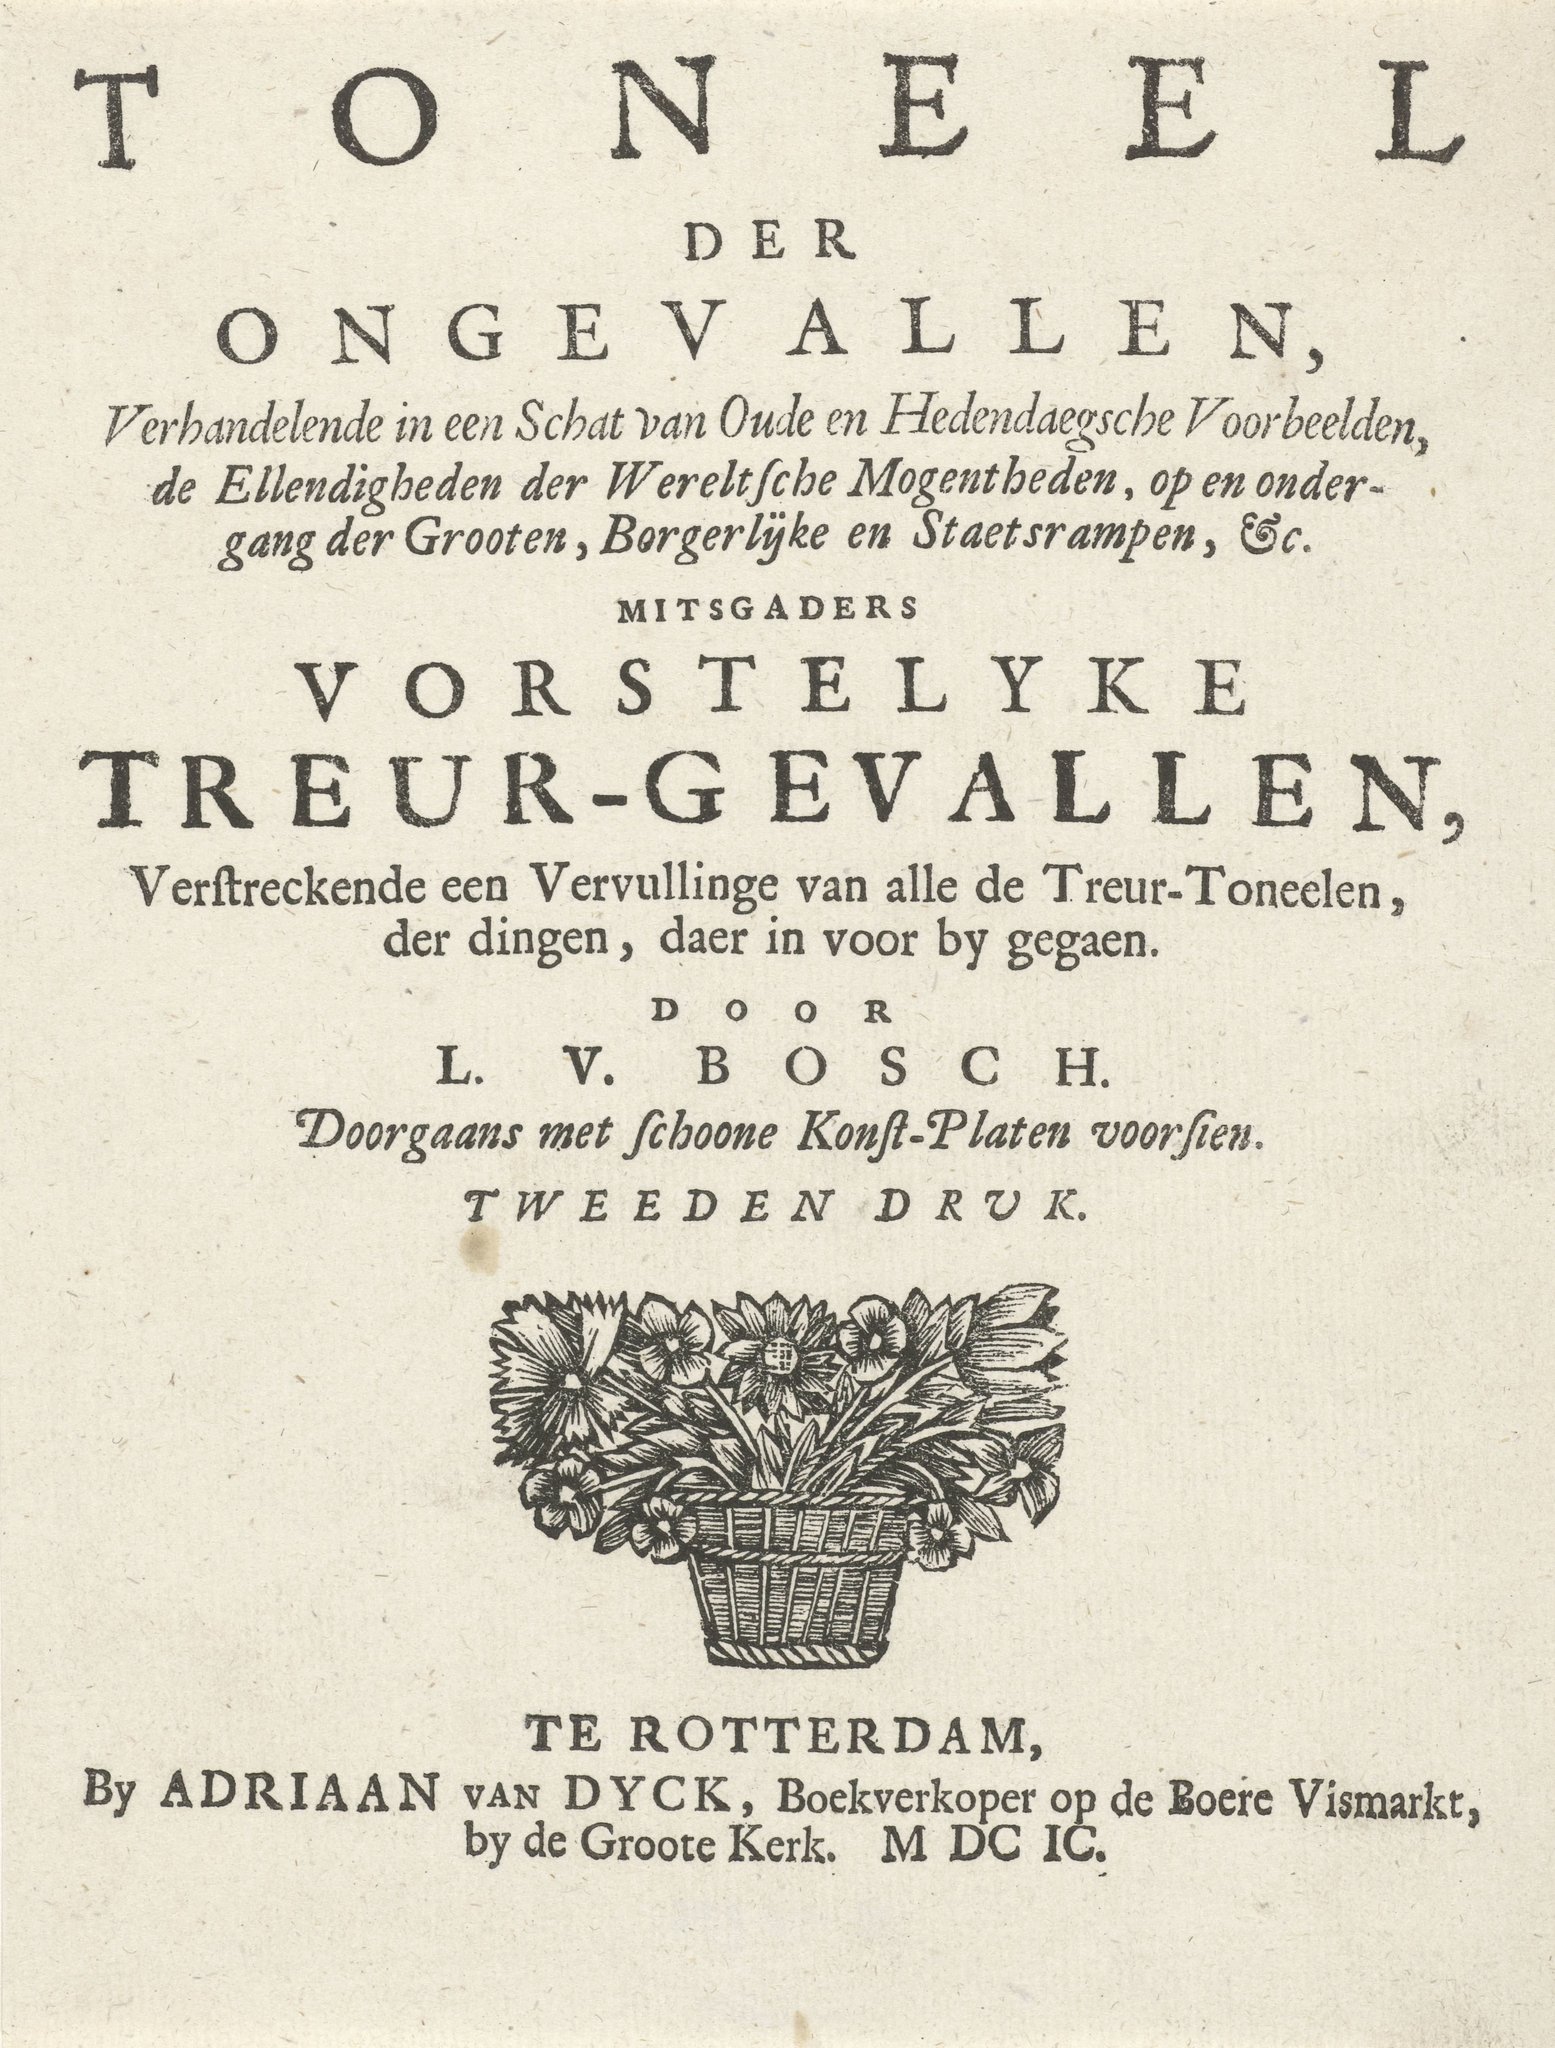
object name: titelblad, titelpagina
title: Titelpagina voor: L. van den Bos, Toneel der ongevallen, en bijspel van vorstelycke treurgevallen, 1699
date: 1699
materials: paper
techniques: etching, letterpress printing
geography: rotterdam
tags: flowers, container made of plant material other than wood: basket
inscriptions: collector's mark: Lugt 2228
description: Een mand met bloemen met daarboven 15 regels in het Nederlands. Onderaan het impressum. Titelpagina voor (de tweede uitgave van) een boek van Lambert van den Bos met in totaal twinting prenten van Arnold Houbraken.